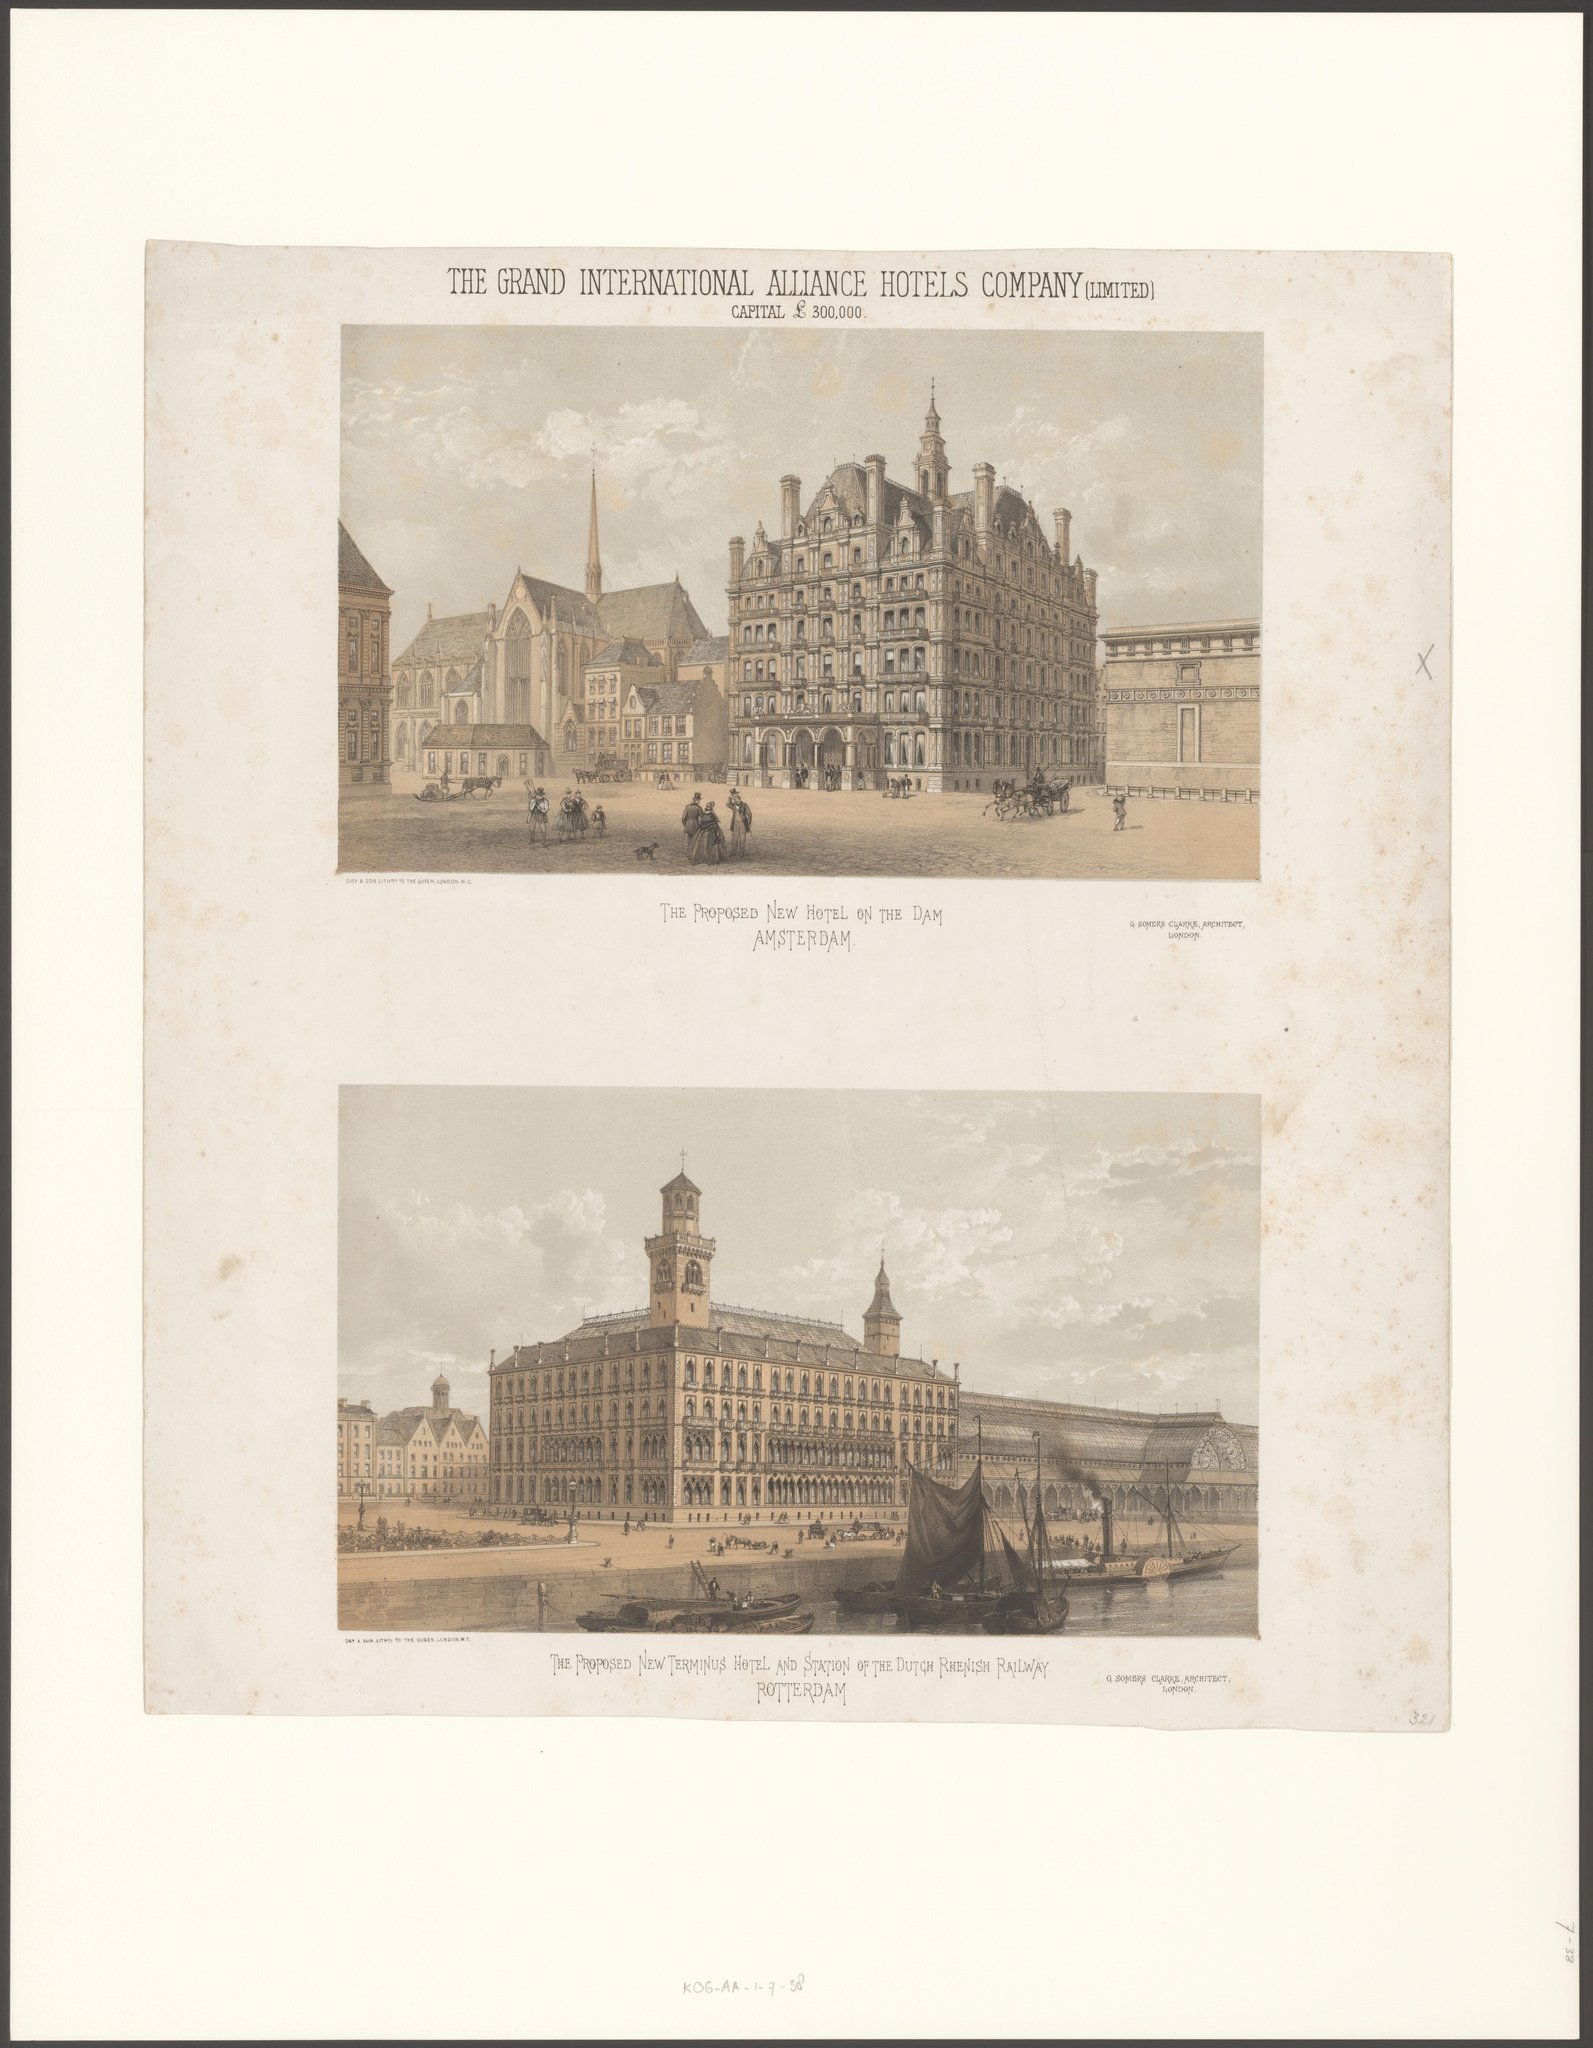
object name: print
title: The proposed New Hotel on the Dam Amsterdam / The proposed New Terminus Hotel and Station of the Dutch Rhenish Railway Rotterdam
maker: Anonymous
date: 1824-1913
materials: paper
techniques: tone lithography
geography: london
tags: square, place, circus, etc., city-view in general; 'veduta', hôtel, i.e. small palace in city, rotterdam, amsterdam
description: Onderwerpsrubriek binnen de Atlas Amsterdam: Dam (na 1835).